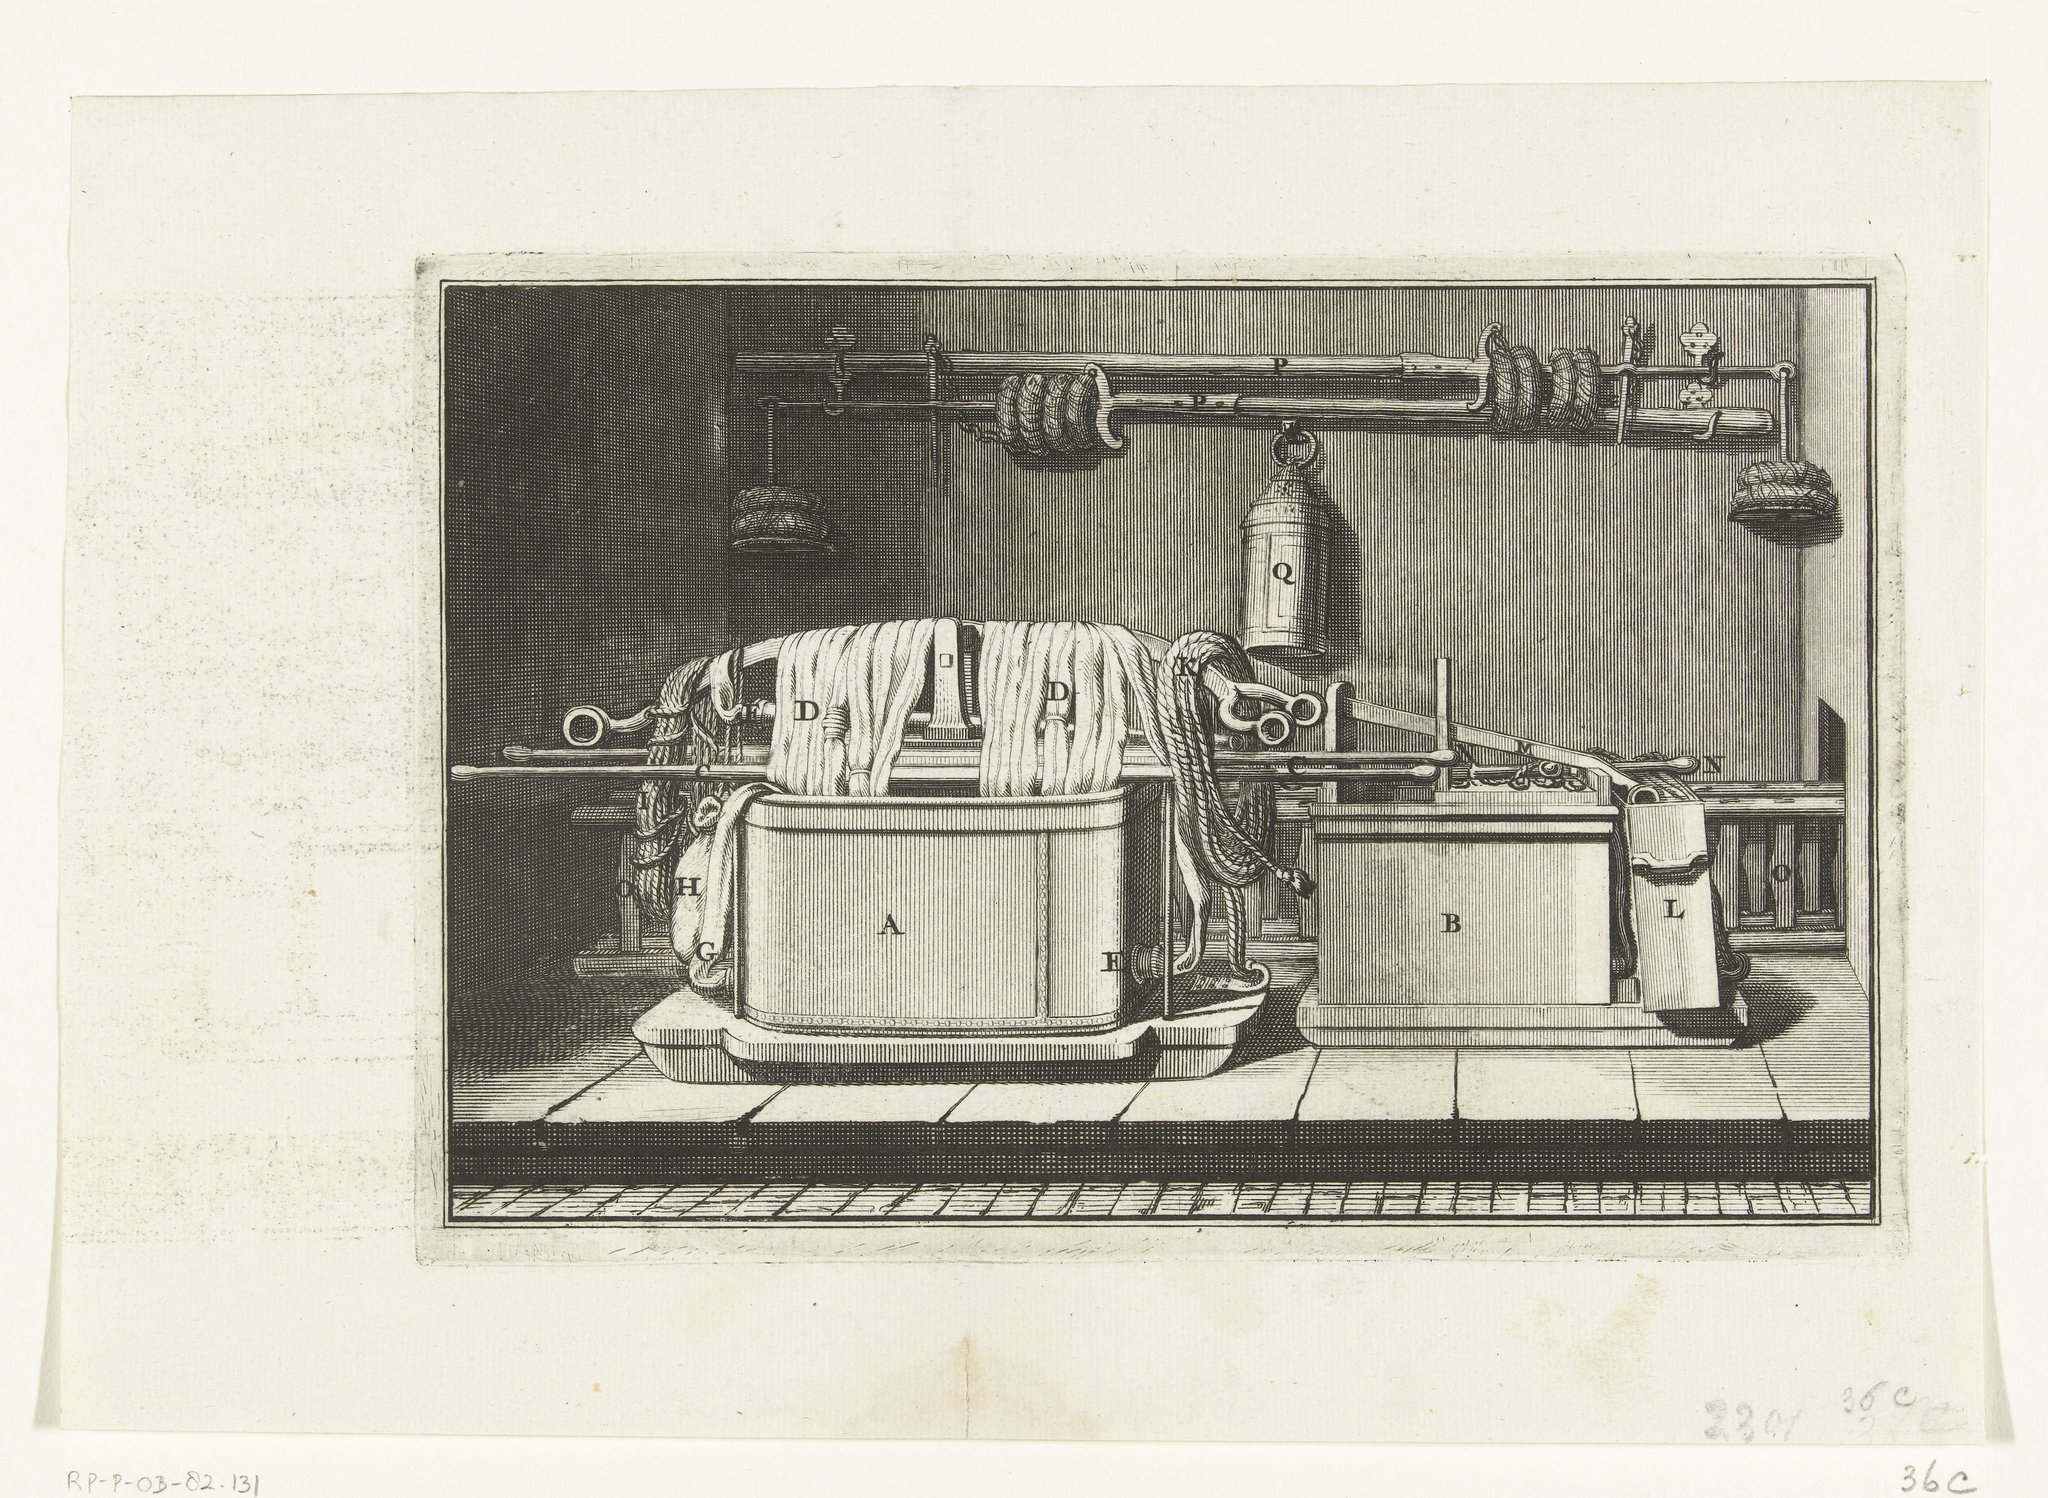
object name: print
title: Slangbrandspuit en pomp opgeborgen in een brandspuithuis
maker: Anonymous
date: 1690-1699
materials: paper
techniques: etching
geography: northern netherlands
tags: amsterdam, painter, print maker, draughtsman, jan van der heyden, fire-extinguishing equipment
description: Een voorstelling hoe de slangbrandspuit en pomp in het brandspuithuisje opgeborgen dient te worden na gebruik. Gebruikt in de instructie over het correcte gebruik en bewaring van de slangbrandspuiten, 1692 en ca. 1695. Behoort tot de bijprenten bij het Brandspuitenboek van Jan van der Heyden.